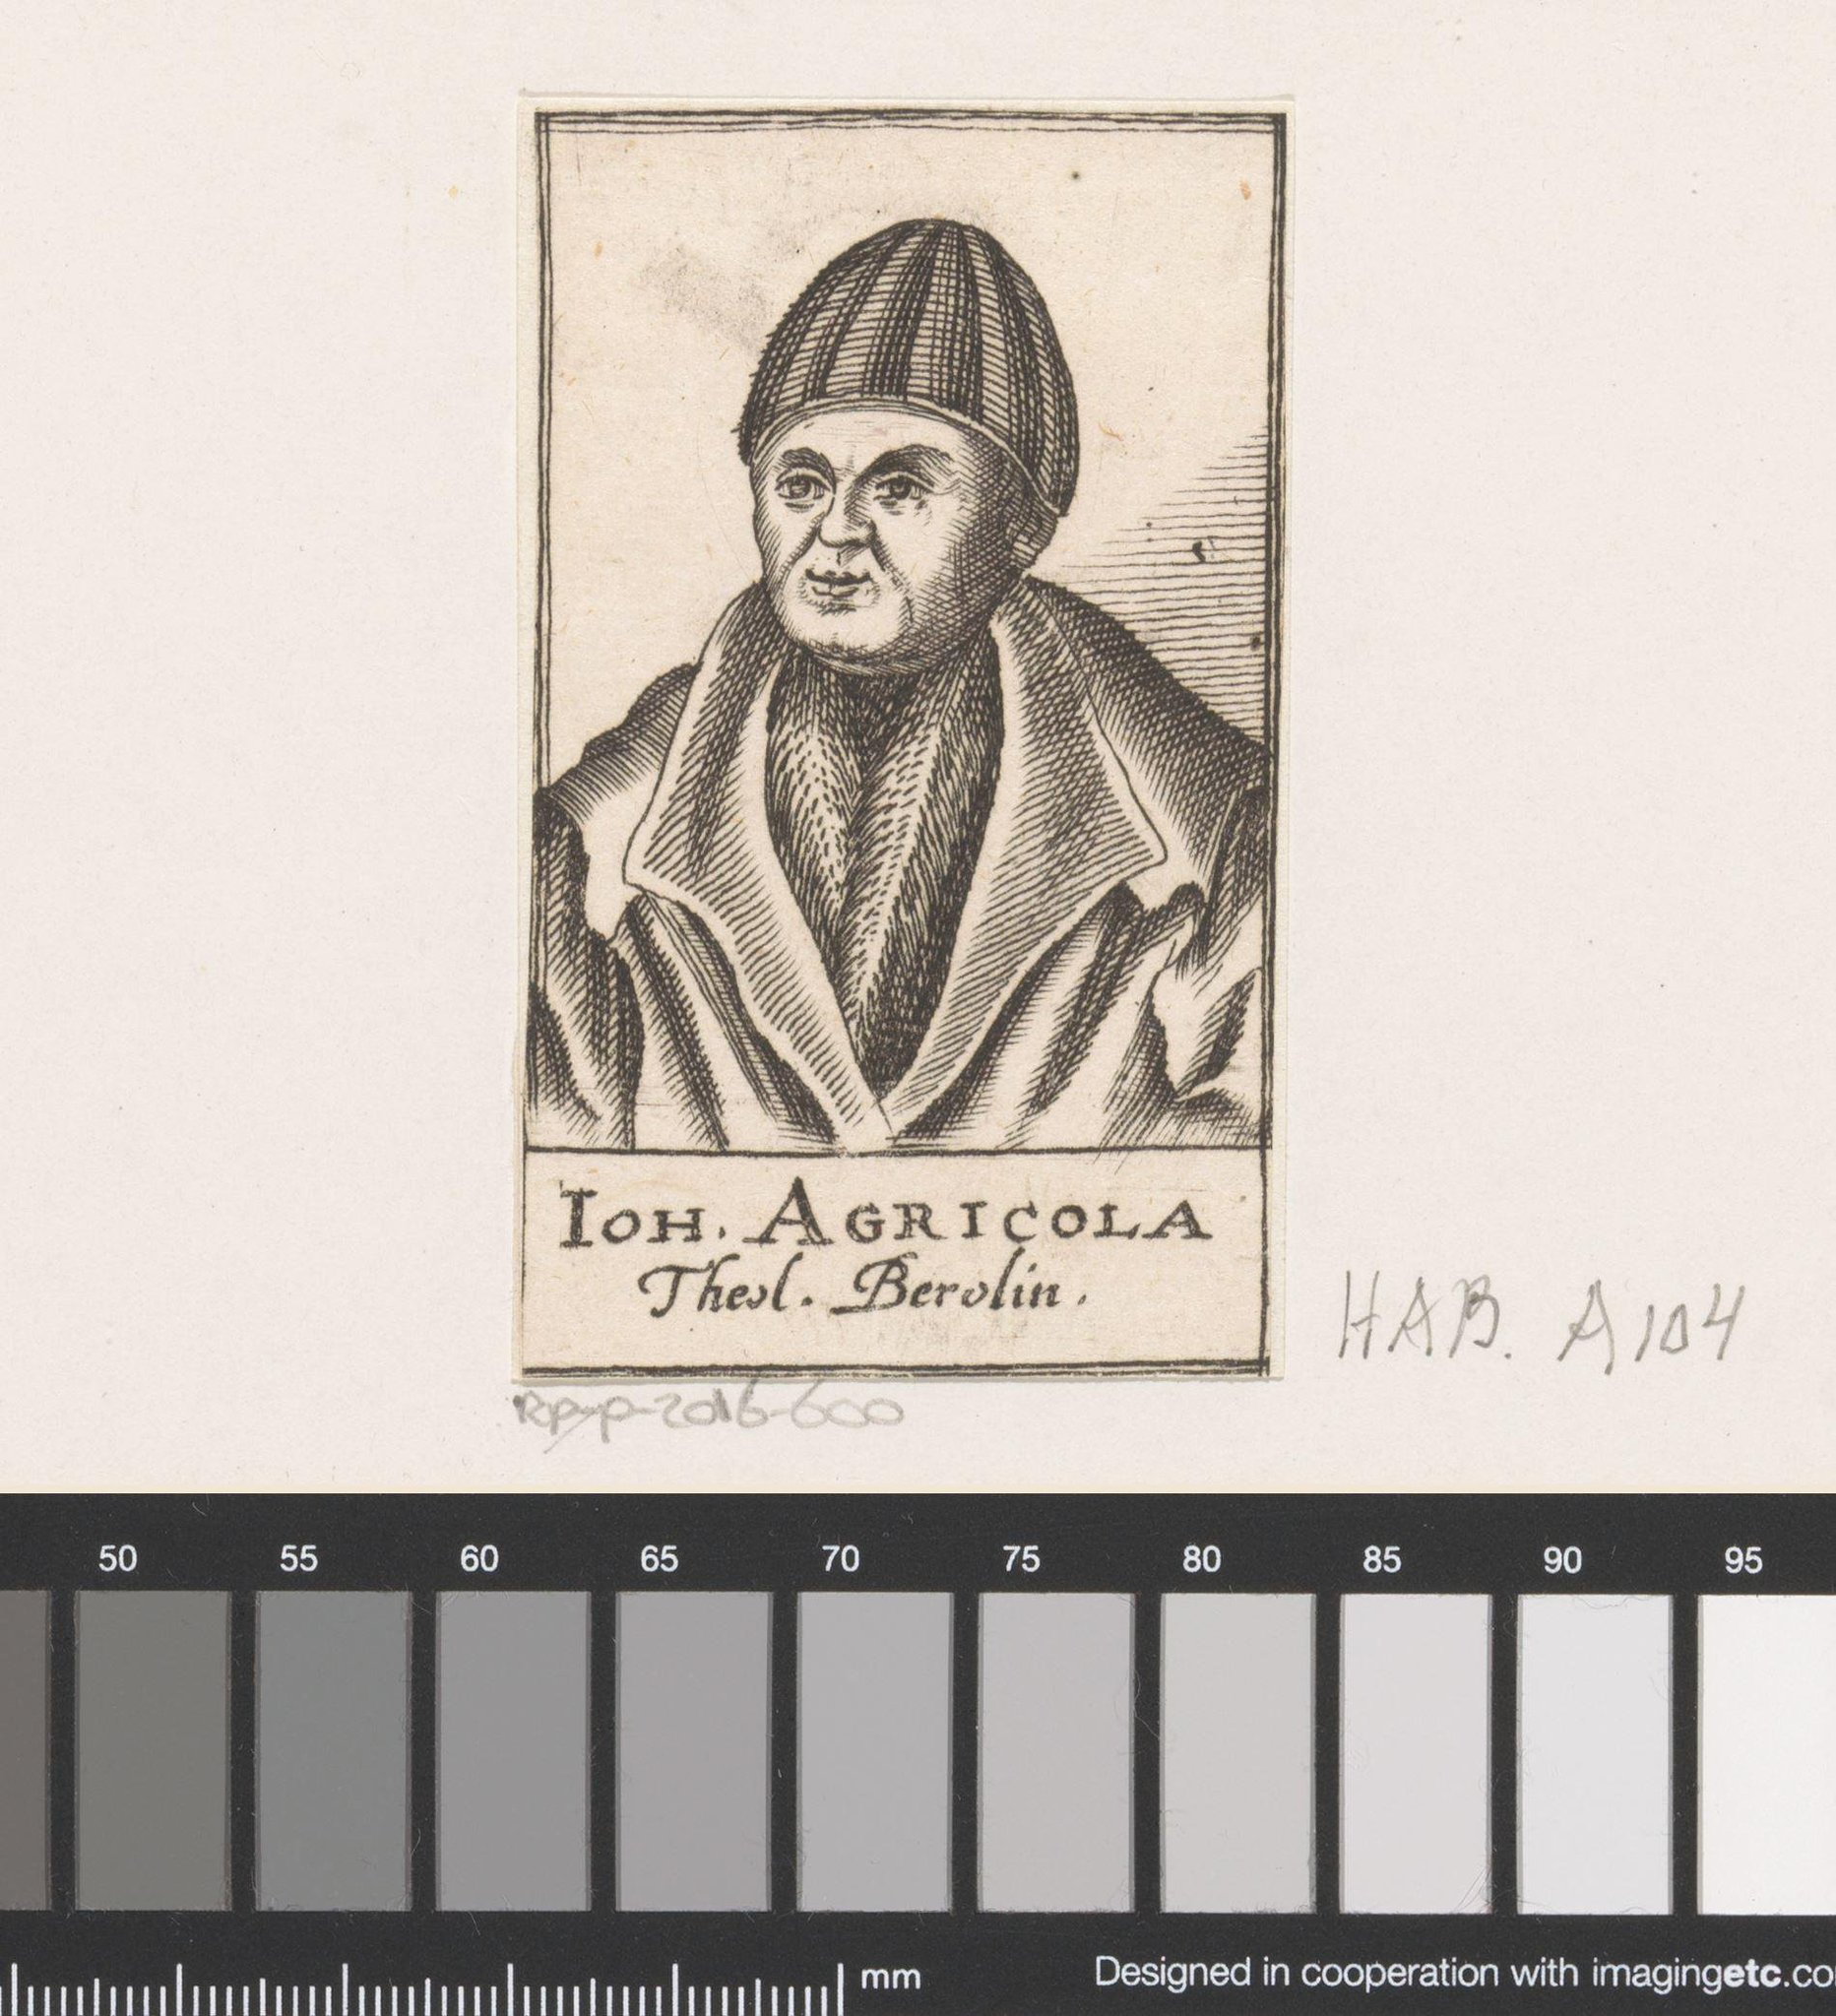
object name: print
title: Portret van Johannes Agricola I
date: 1688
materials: paper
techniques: engraving, etching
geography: nuremberg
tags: berlin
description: Portret van Johannes Agricola I in een rechthoekige omlijsting. In een kader zijn naam en beroep.